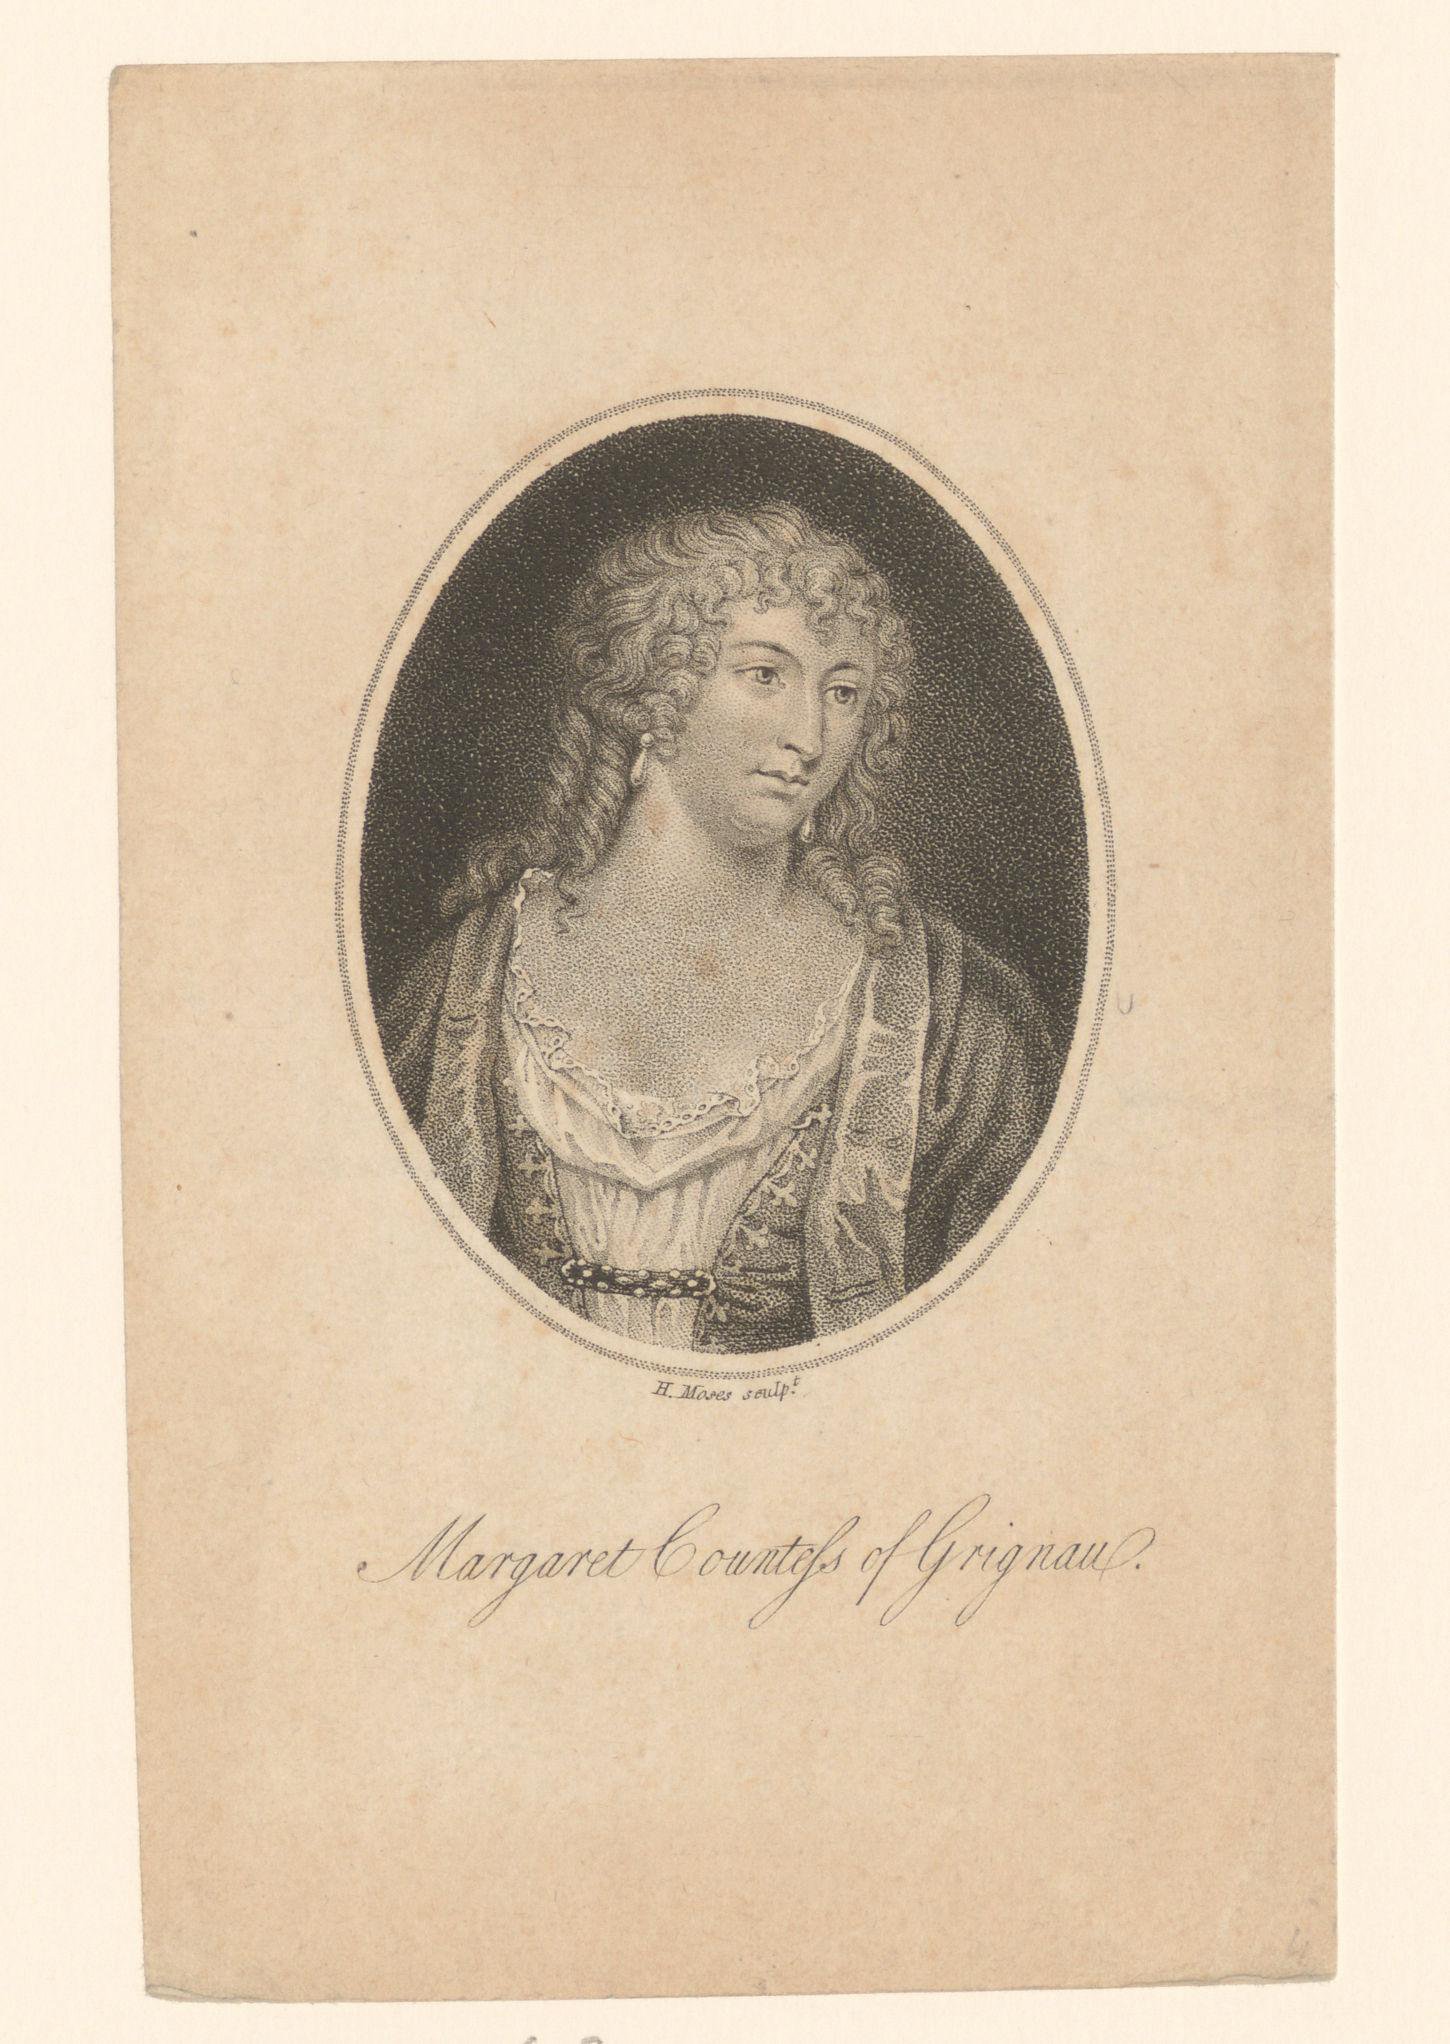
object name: print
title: Margaret Countess of Grignau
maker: henry moses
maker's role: print maker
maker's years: 1782-1870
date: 1792-1870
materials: paper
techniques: etching, engraving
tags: paris, historical persons - bb - woman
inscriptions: collector's mark: Lugt 2228